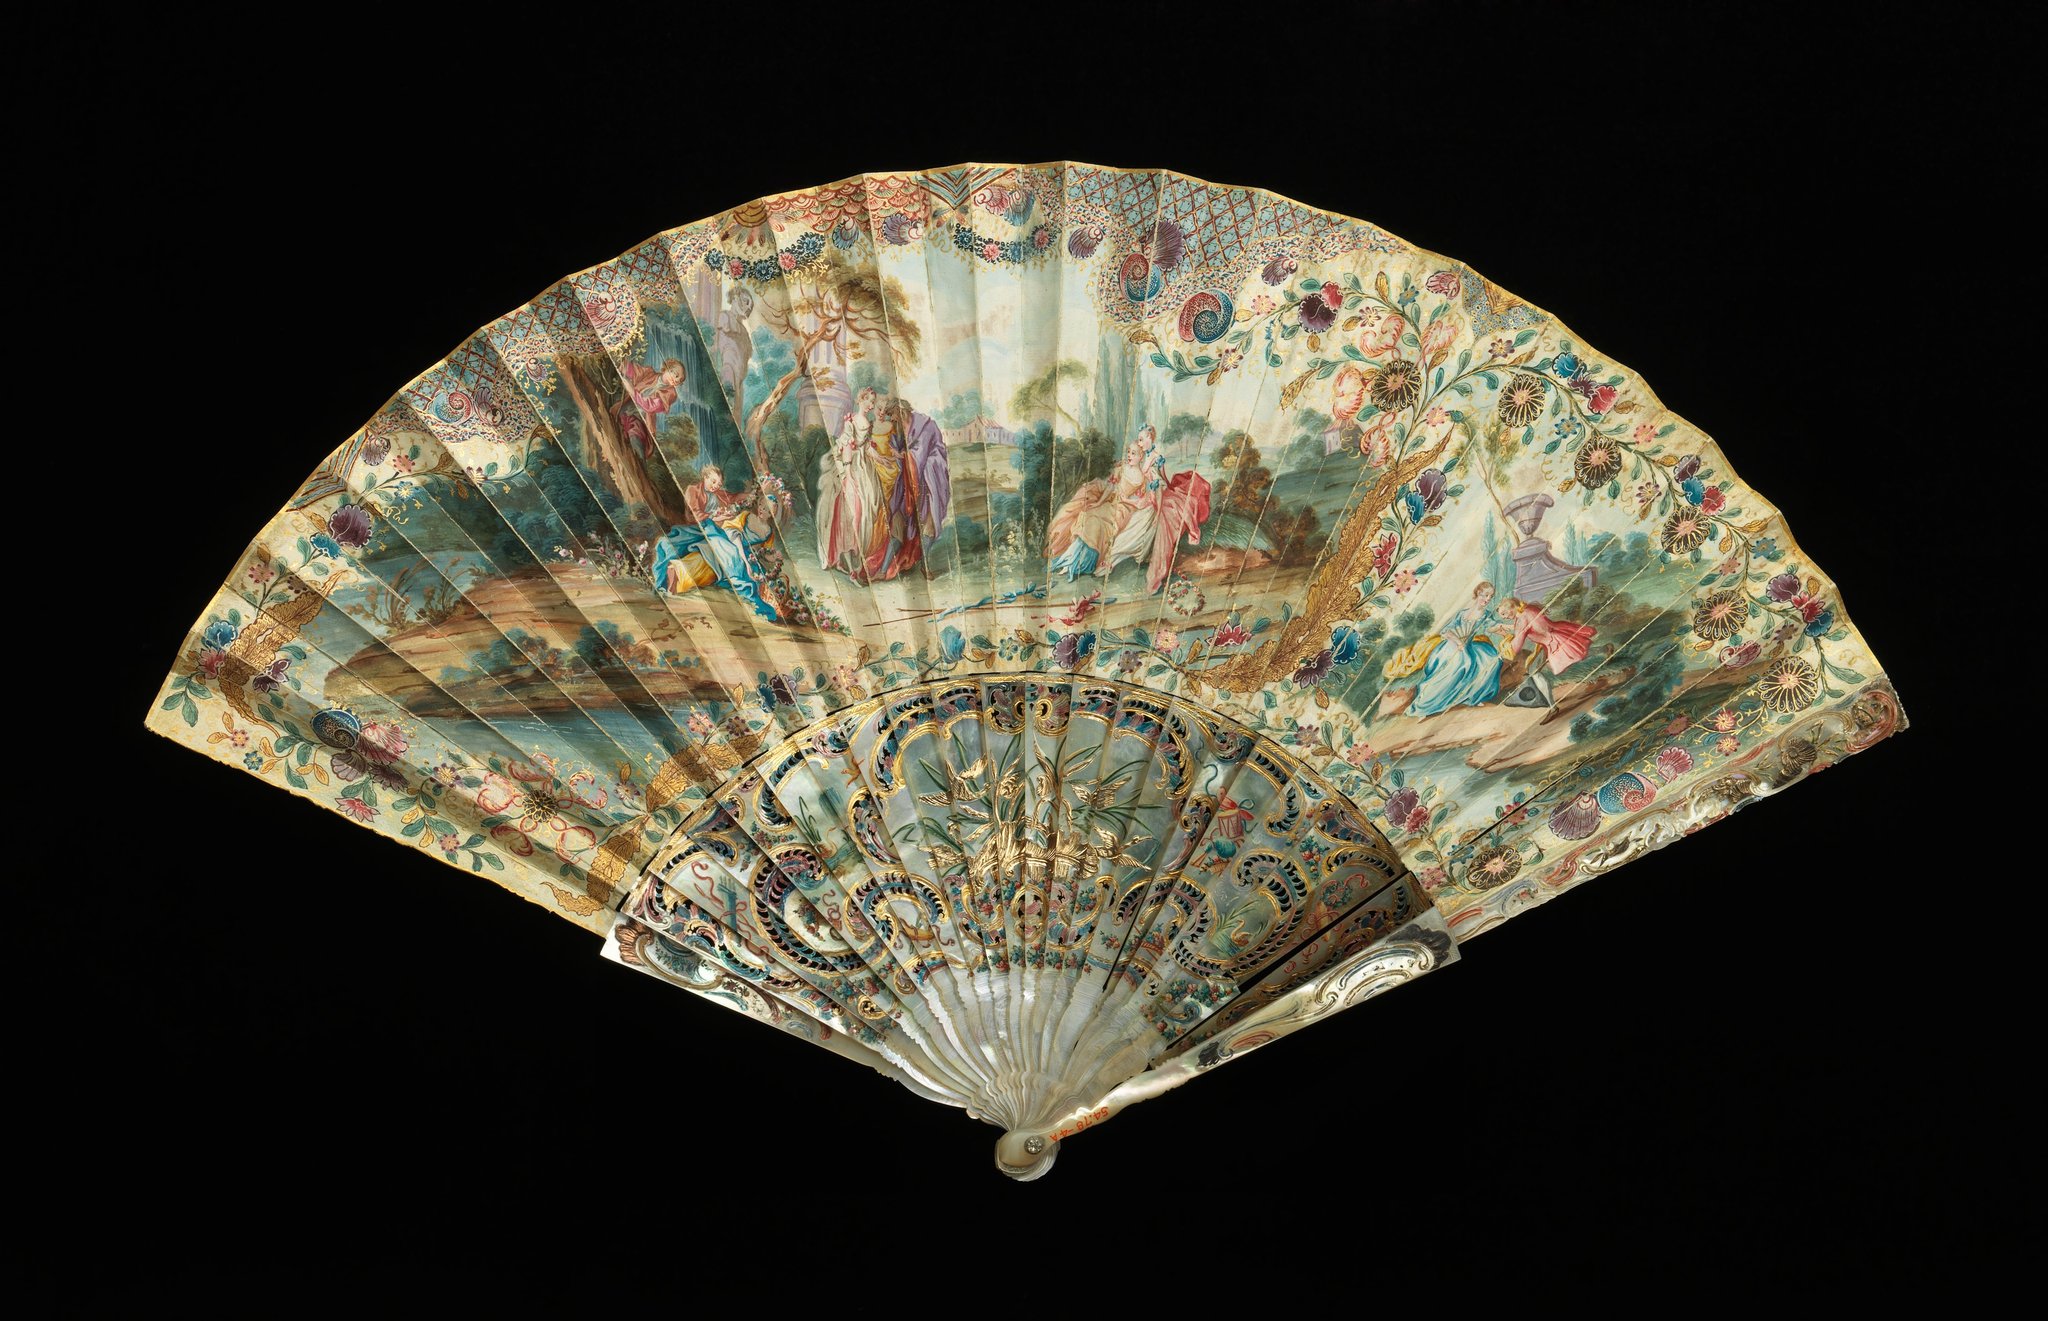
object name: fan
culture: french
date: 1751-1775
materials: gouache, mother of pearl, paper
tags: men,women